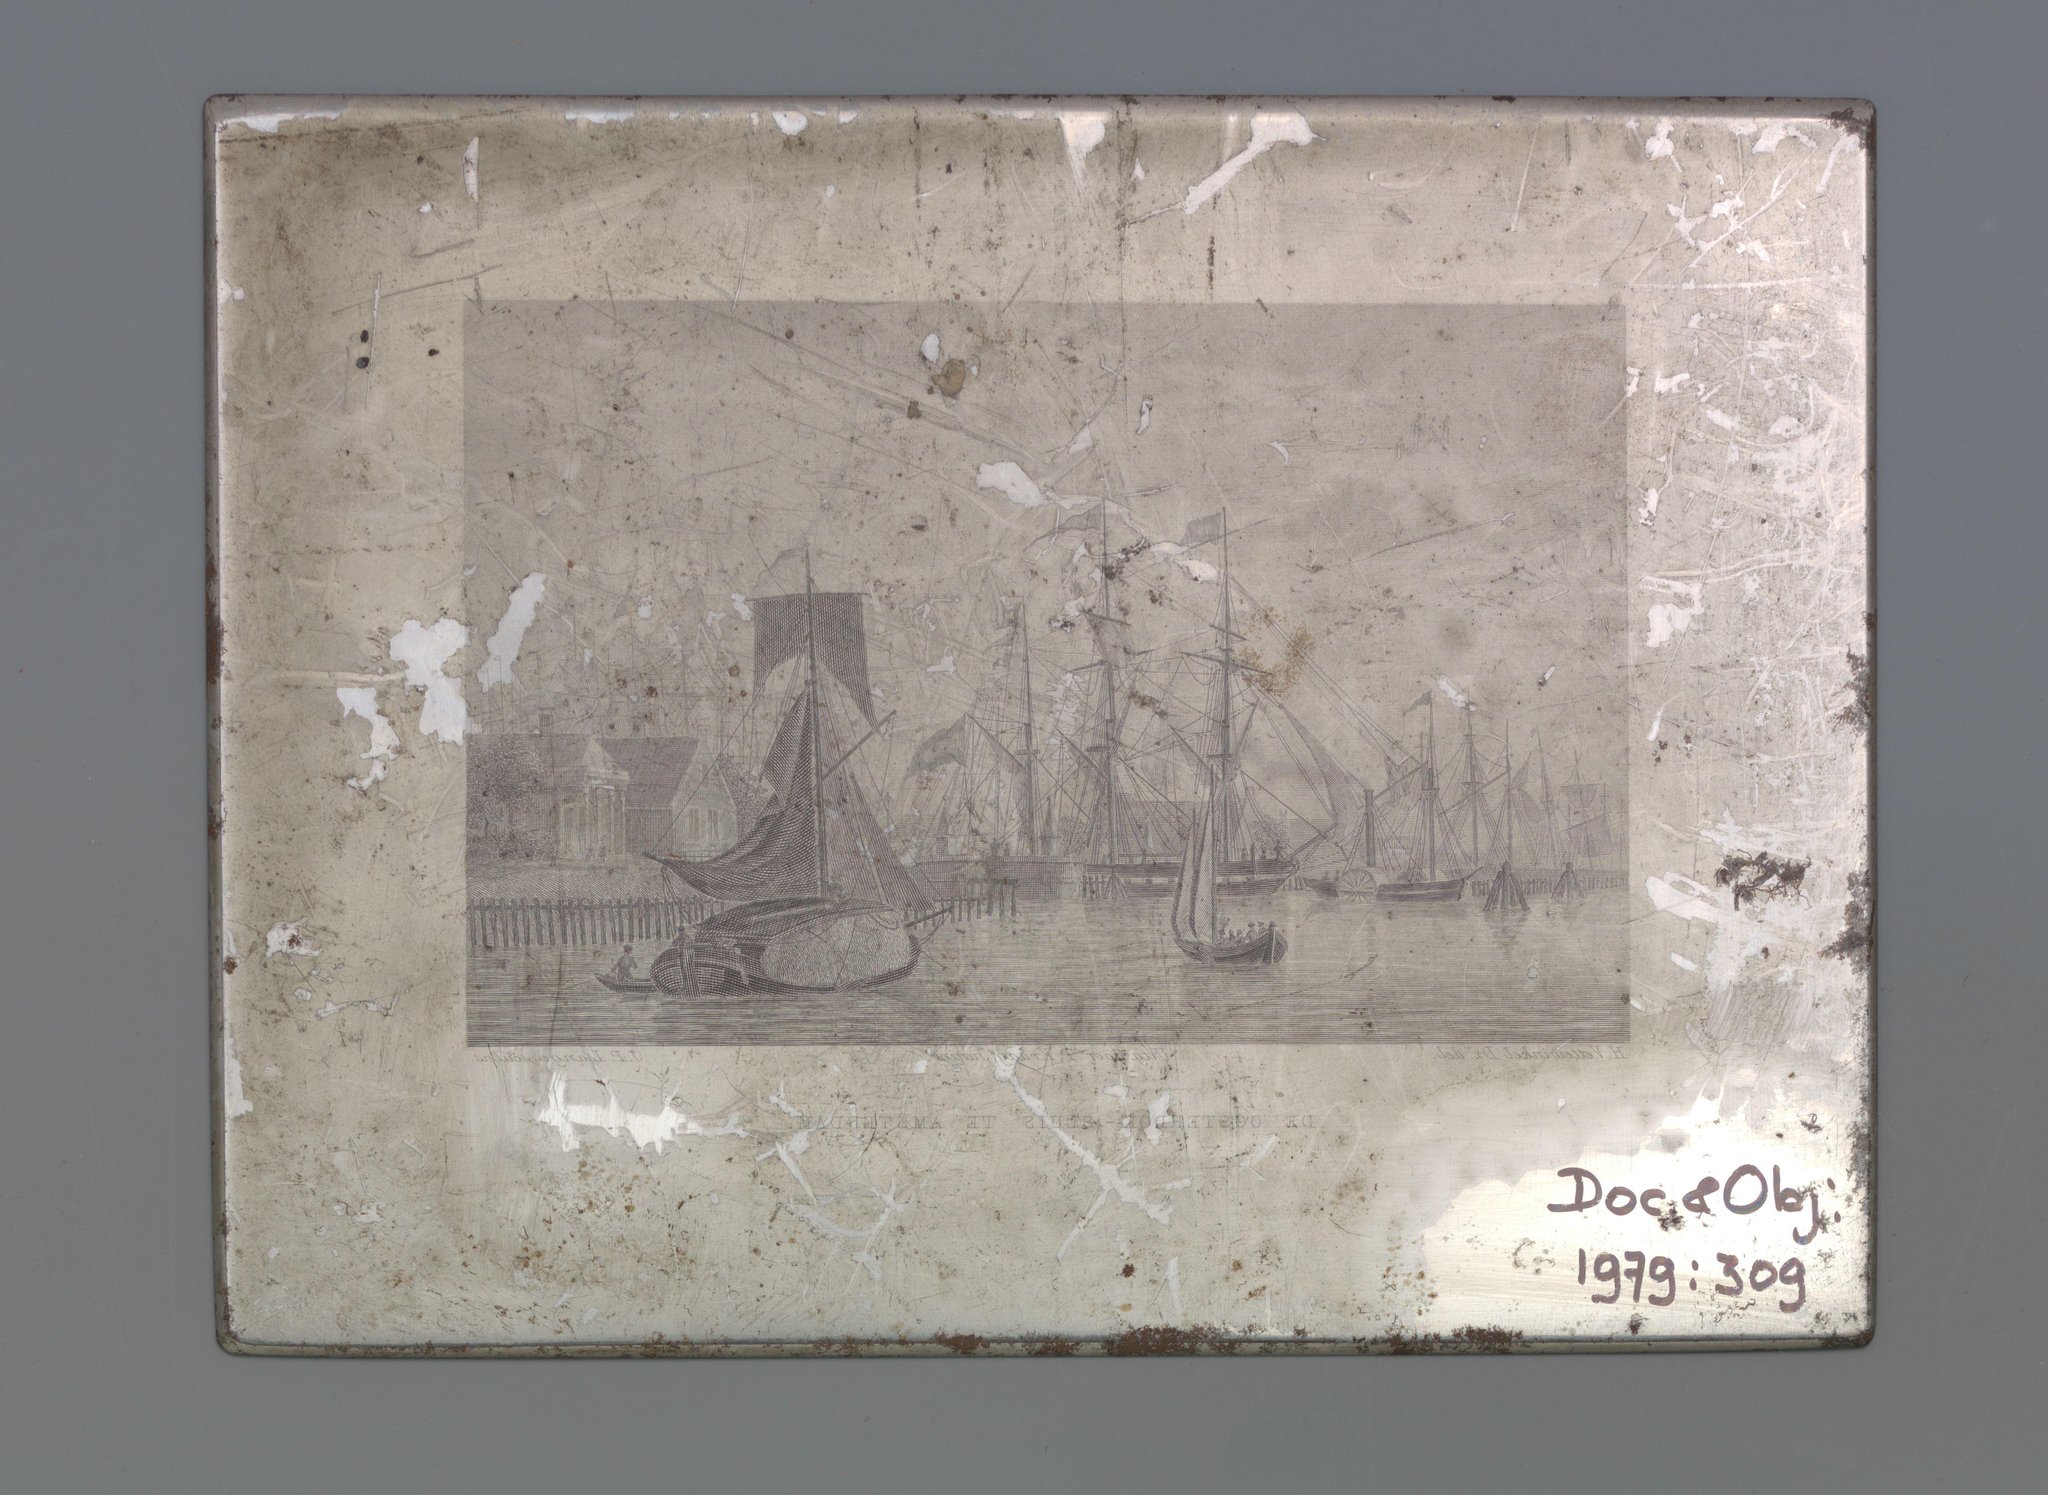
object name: staalplaat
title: Oosterdokshuis te Amsterdam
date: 1820-1849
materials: steel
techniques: engraving